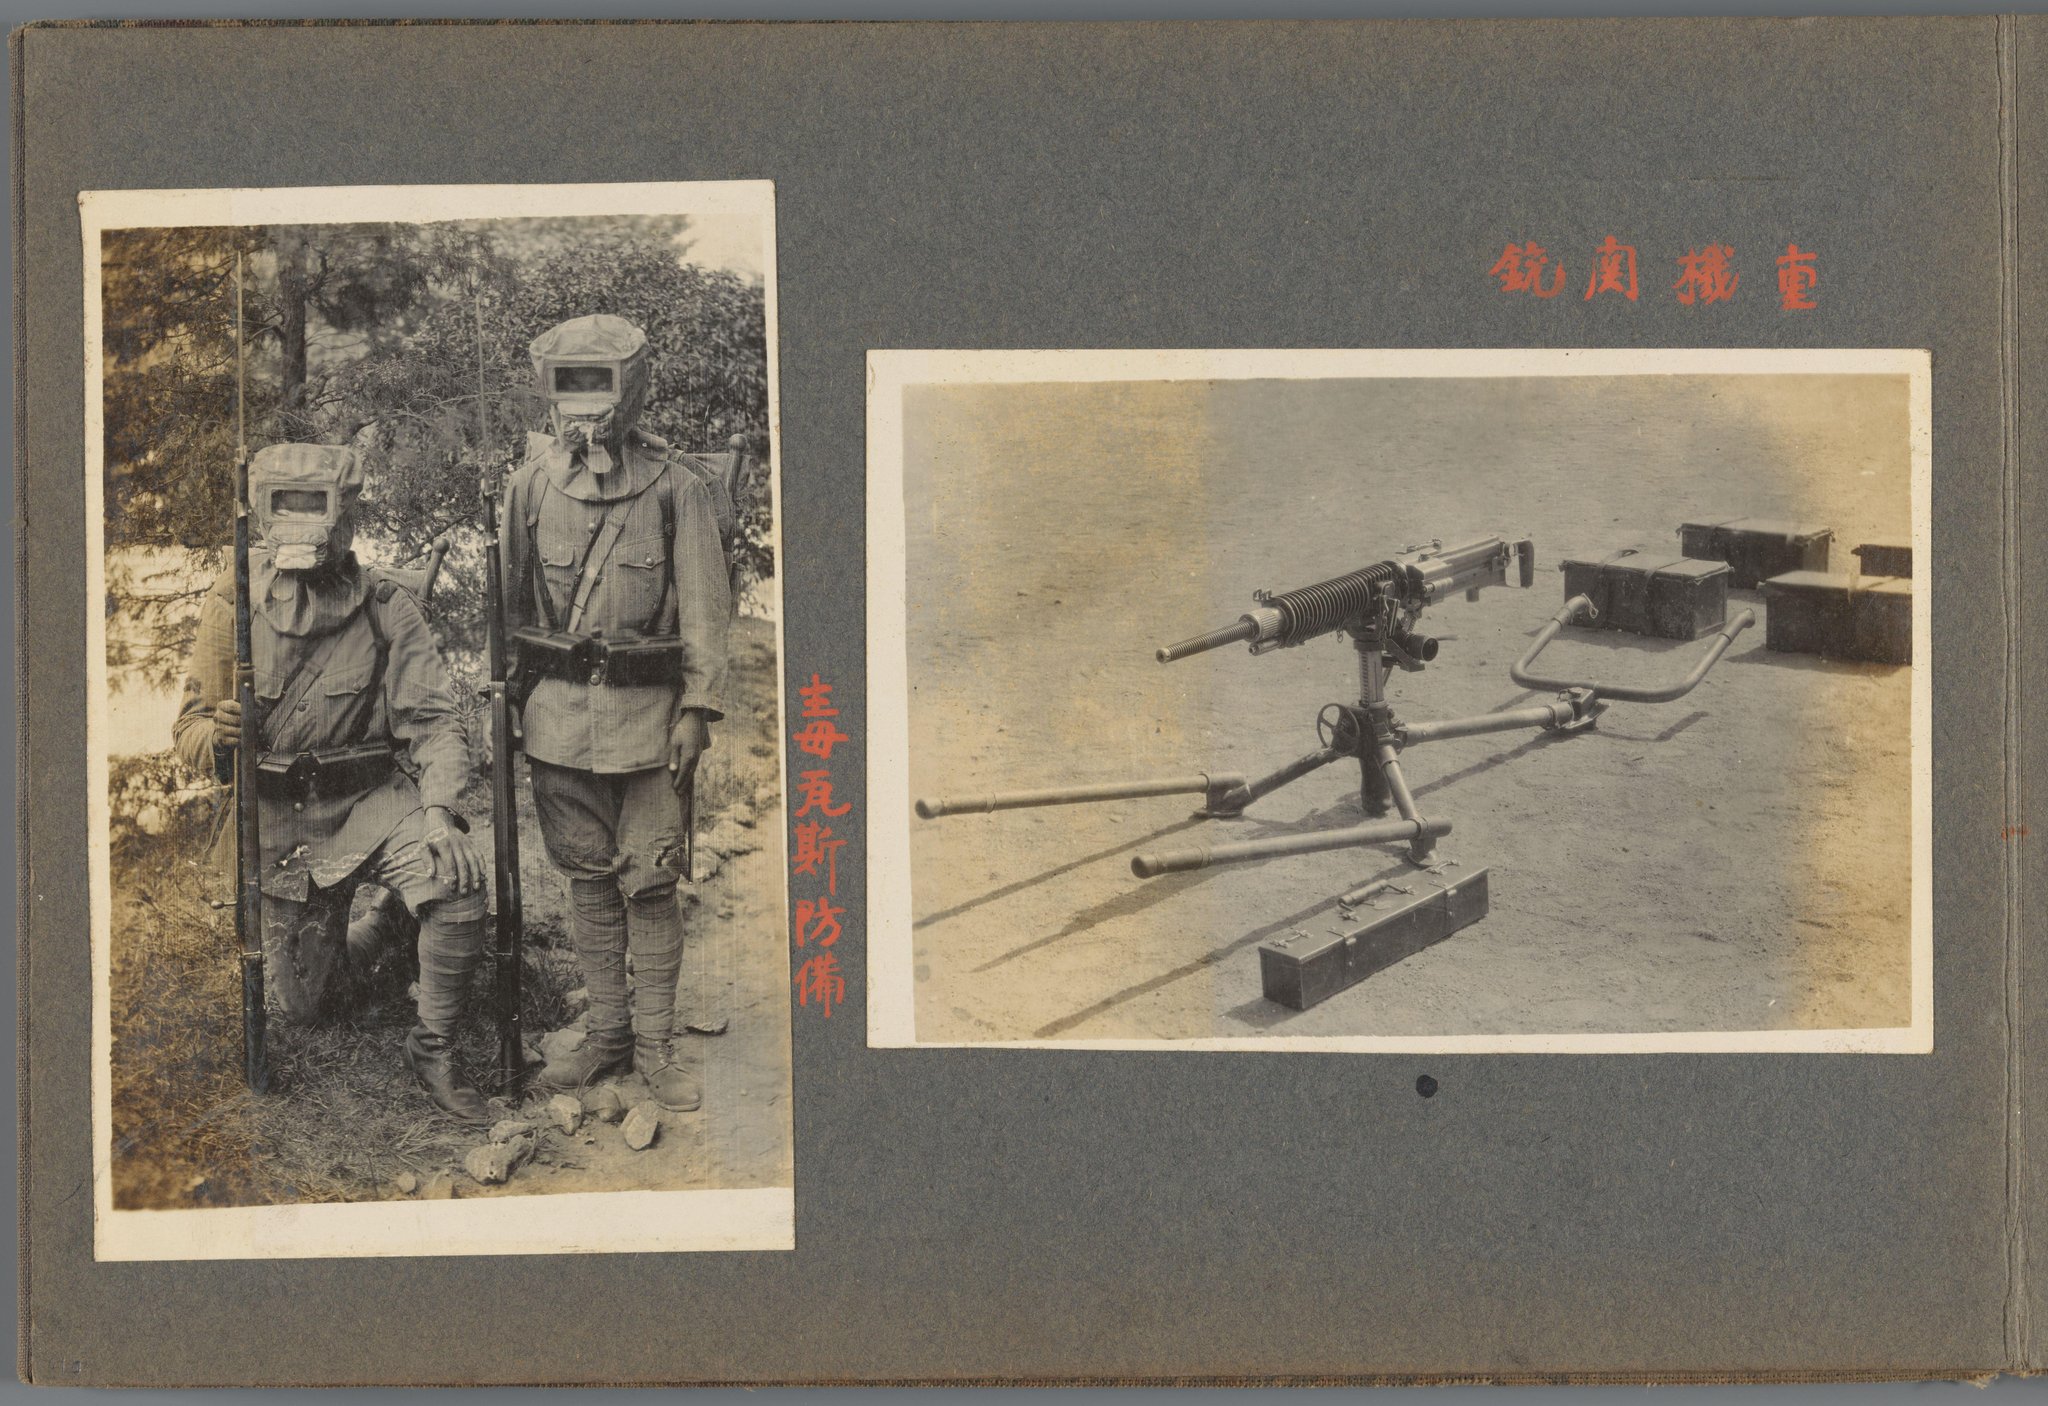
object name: photograph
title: Oefening met gasmaskers en mitrailleur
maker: Anonymous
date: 1930-1940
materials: cardboard, photographic support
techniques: gelatin silver print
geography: japan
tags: protective weapons (with name), firearms (with name), military training, japan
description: Albumblad met twee foto's van het leven van Japanse militairen. Bij de foto's opschriften in het Japans. Onderdeel van het leporello fotoalbum met foto’s van de diensttijd van Japanse militairen.